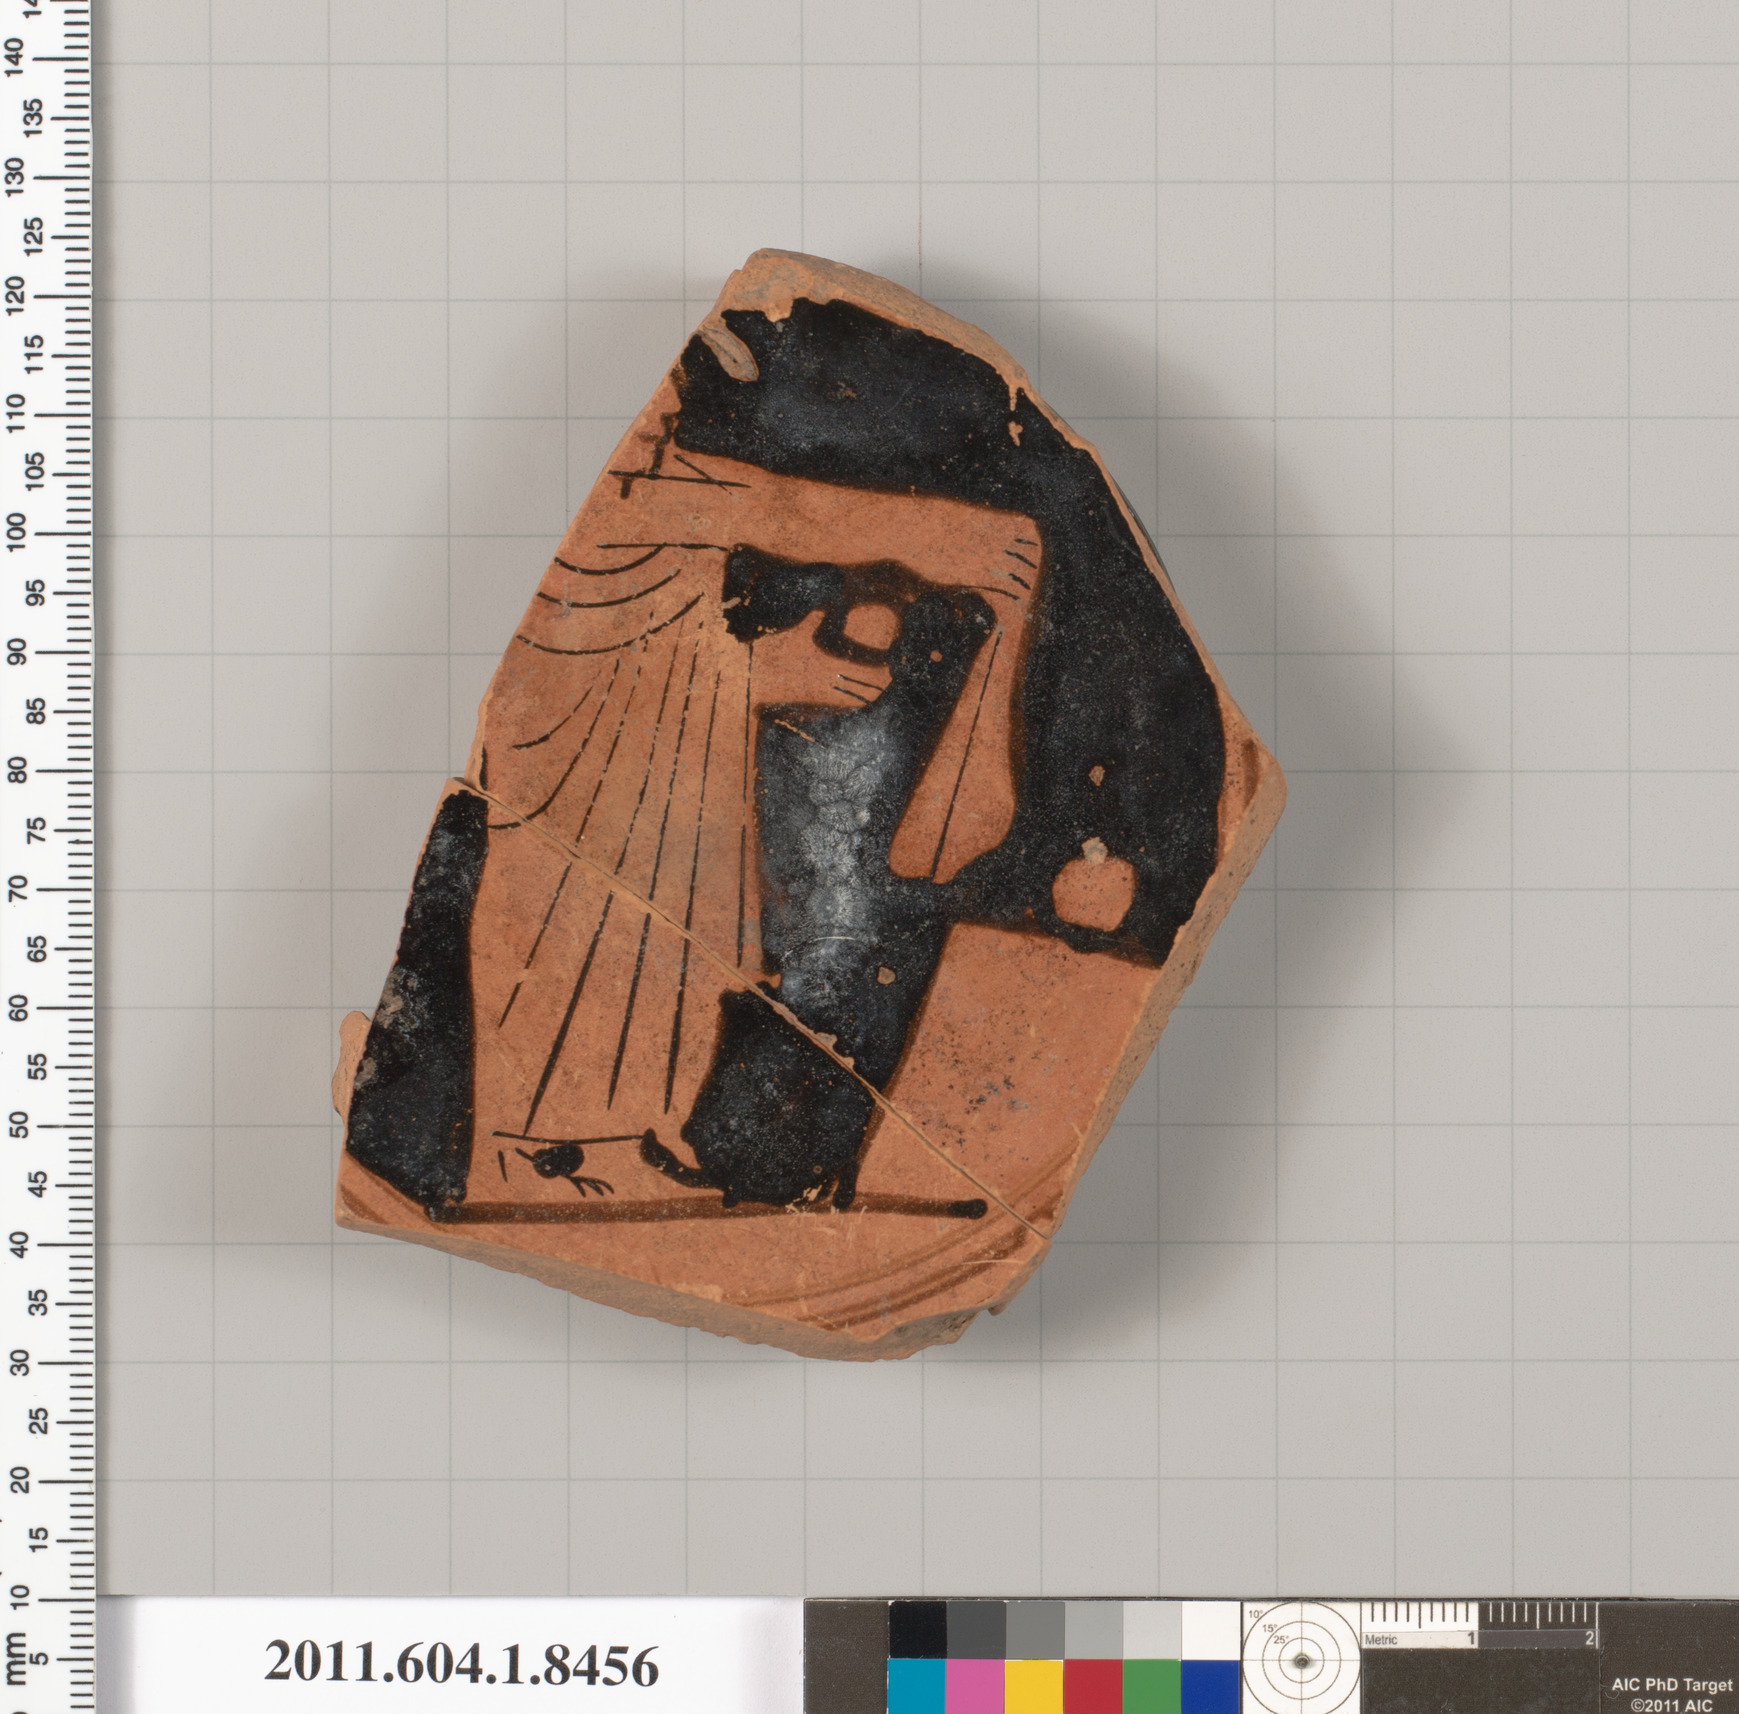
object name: kylix fragment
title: Terracotta fragment of a stemless kylix (drinking cup)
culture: greek, attic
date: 451-500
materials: terracotta